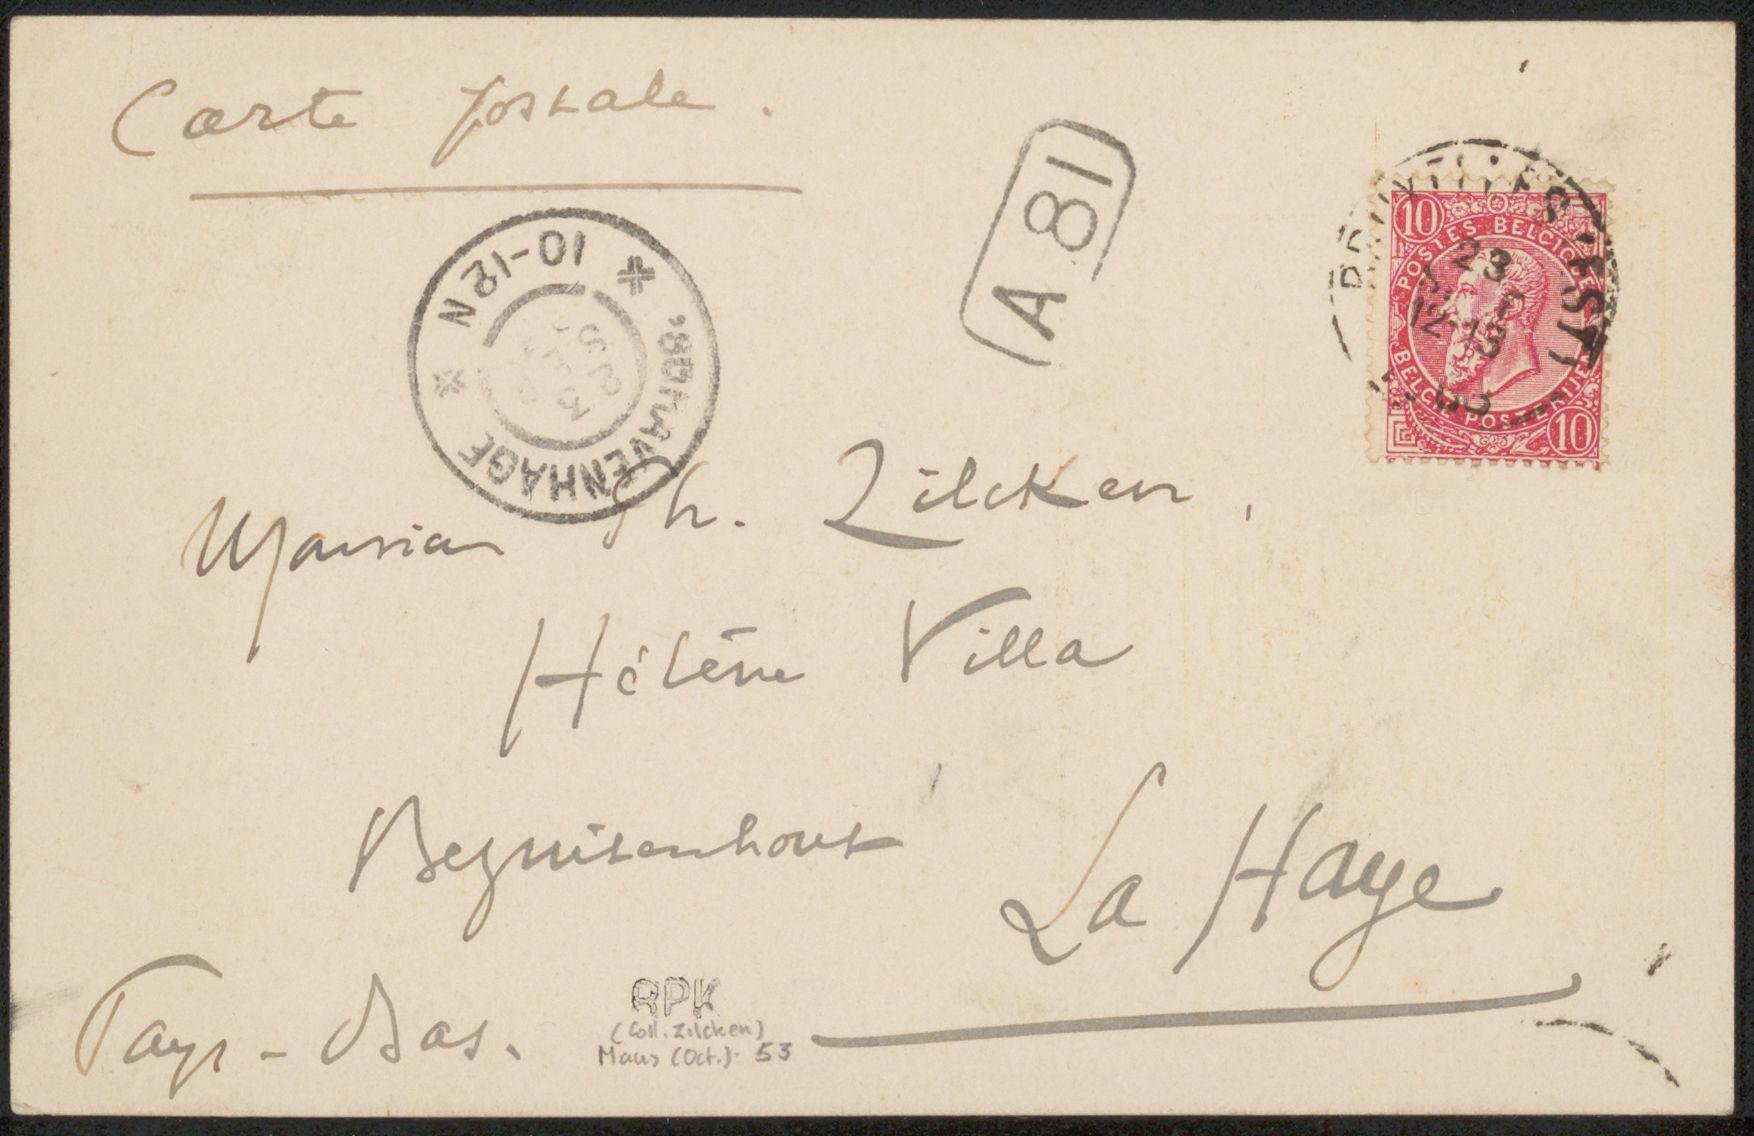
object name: letter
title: Brief aan Philip Zilcken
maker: octave maus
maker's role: painter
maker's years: 1856-1919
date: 1903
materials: cardboard, ink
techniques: pen, printing, writing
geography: brussels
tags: the hague, painter, draughtsman, philip zilcken, exhibition ~ art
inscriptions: collector's mark: ‘RPK’